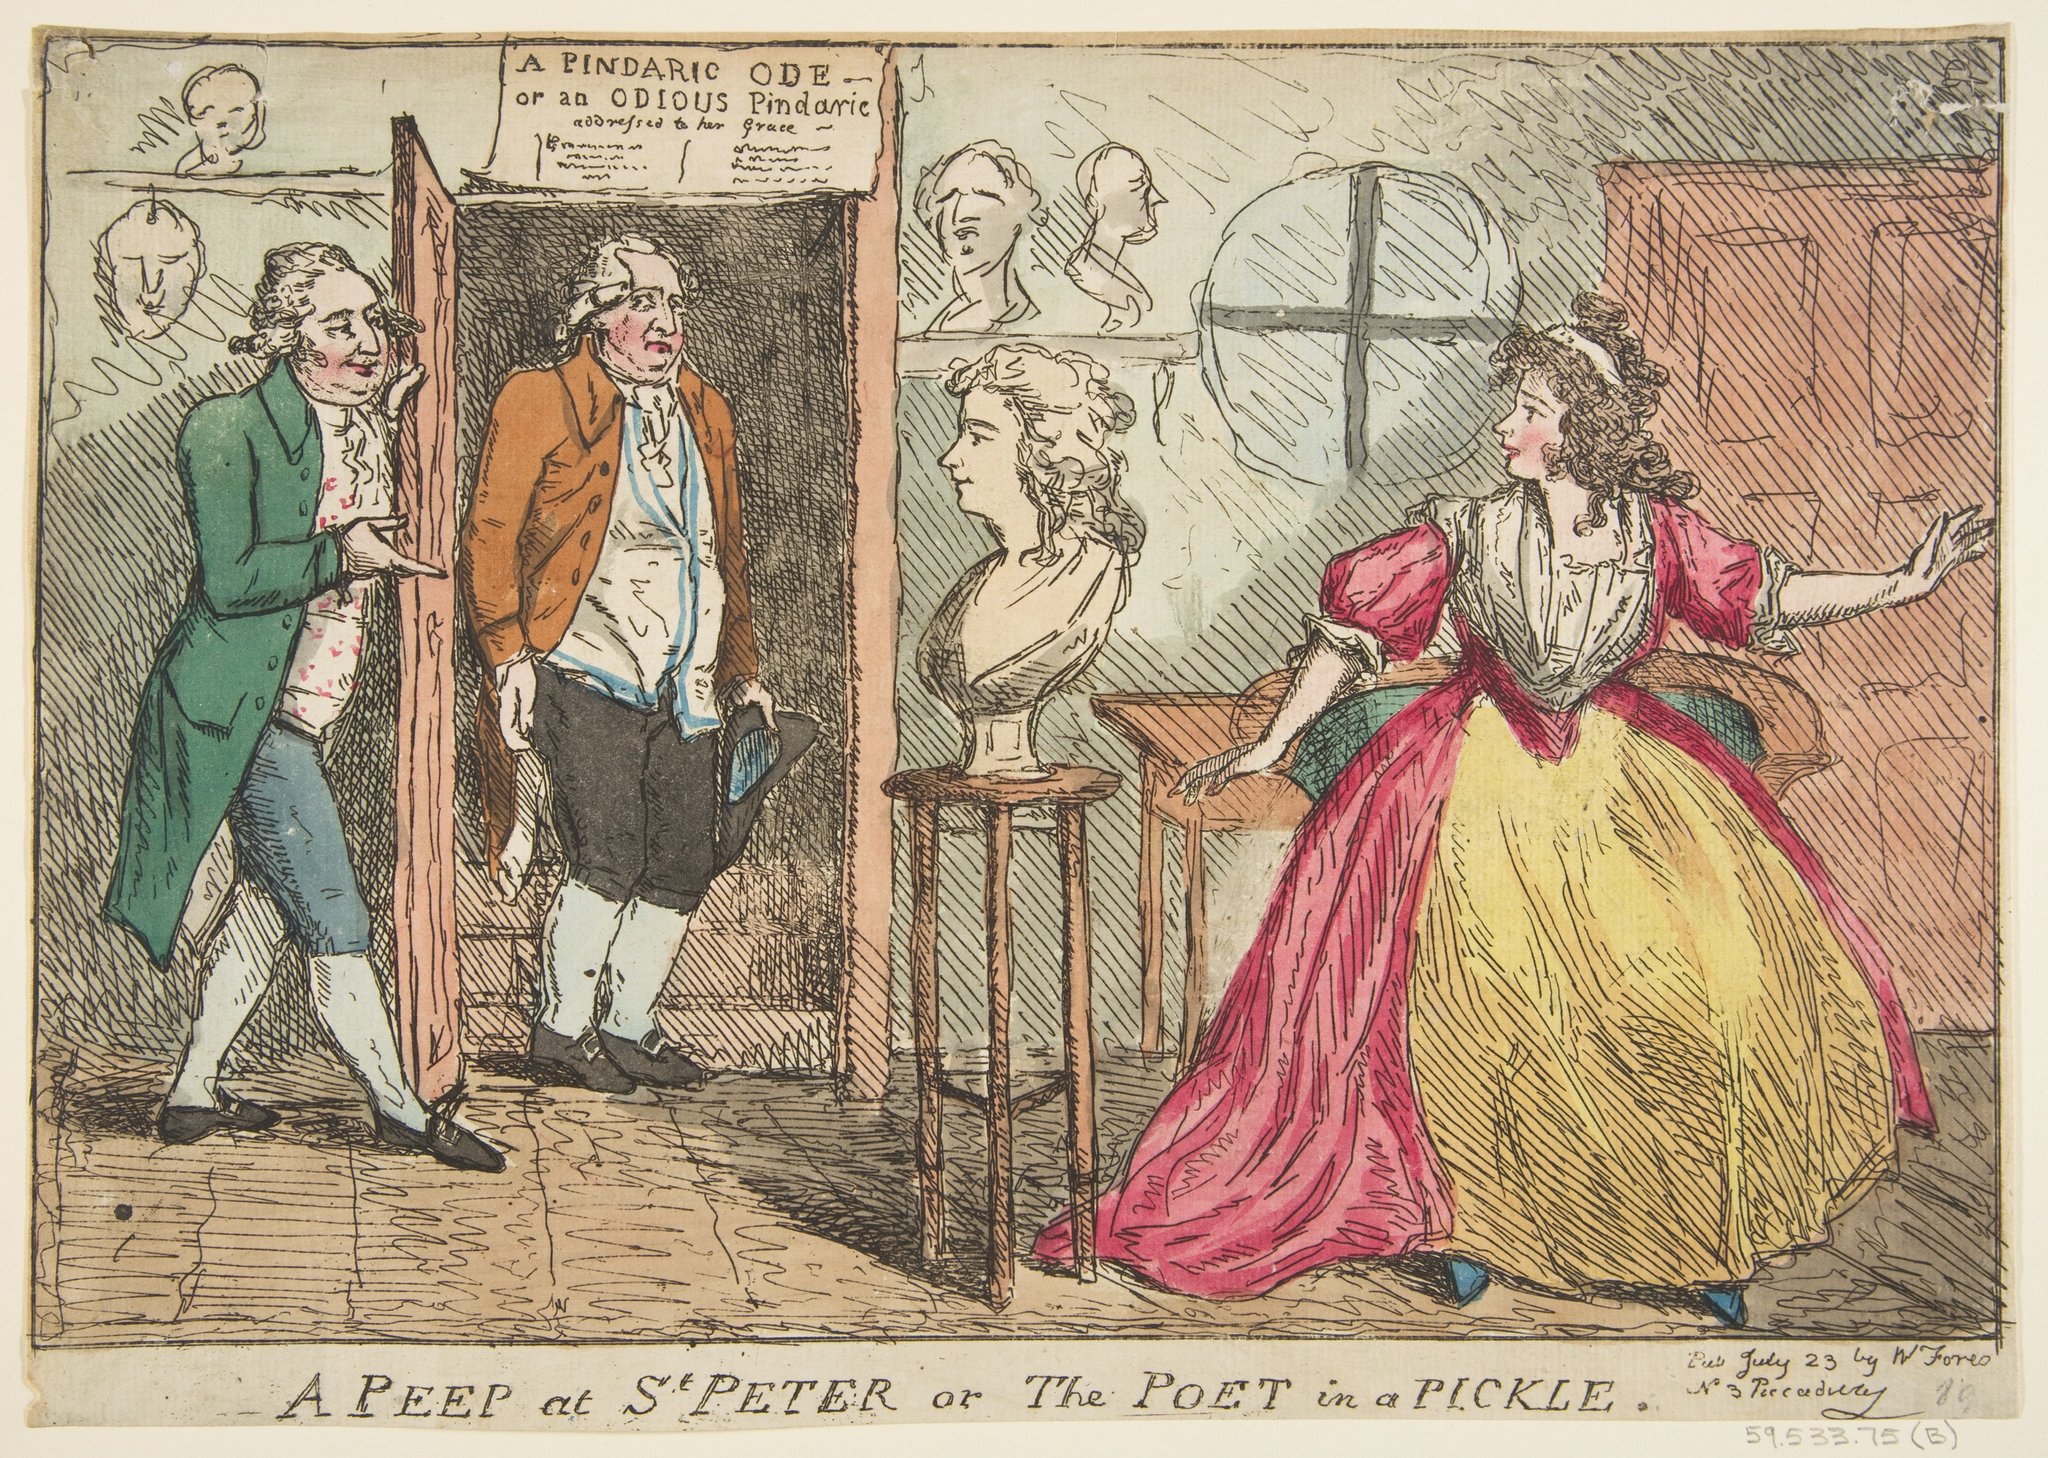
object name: print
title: A Peep at St. Peter or The Poet in a Pickle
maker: anonymous, british, 18th century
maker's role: artist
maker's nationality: british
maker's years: 1700-1800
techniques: etching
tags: satire,men,women